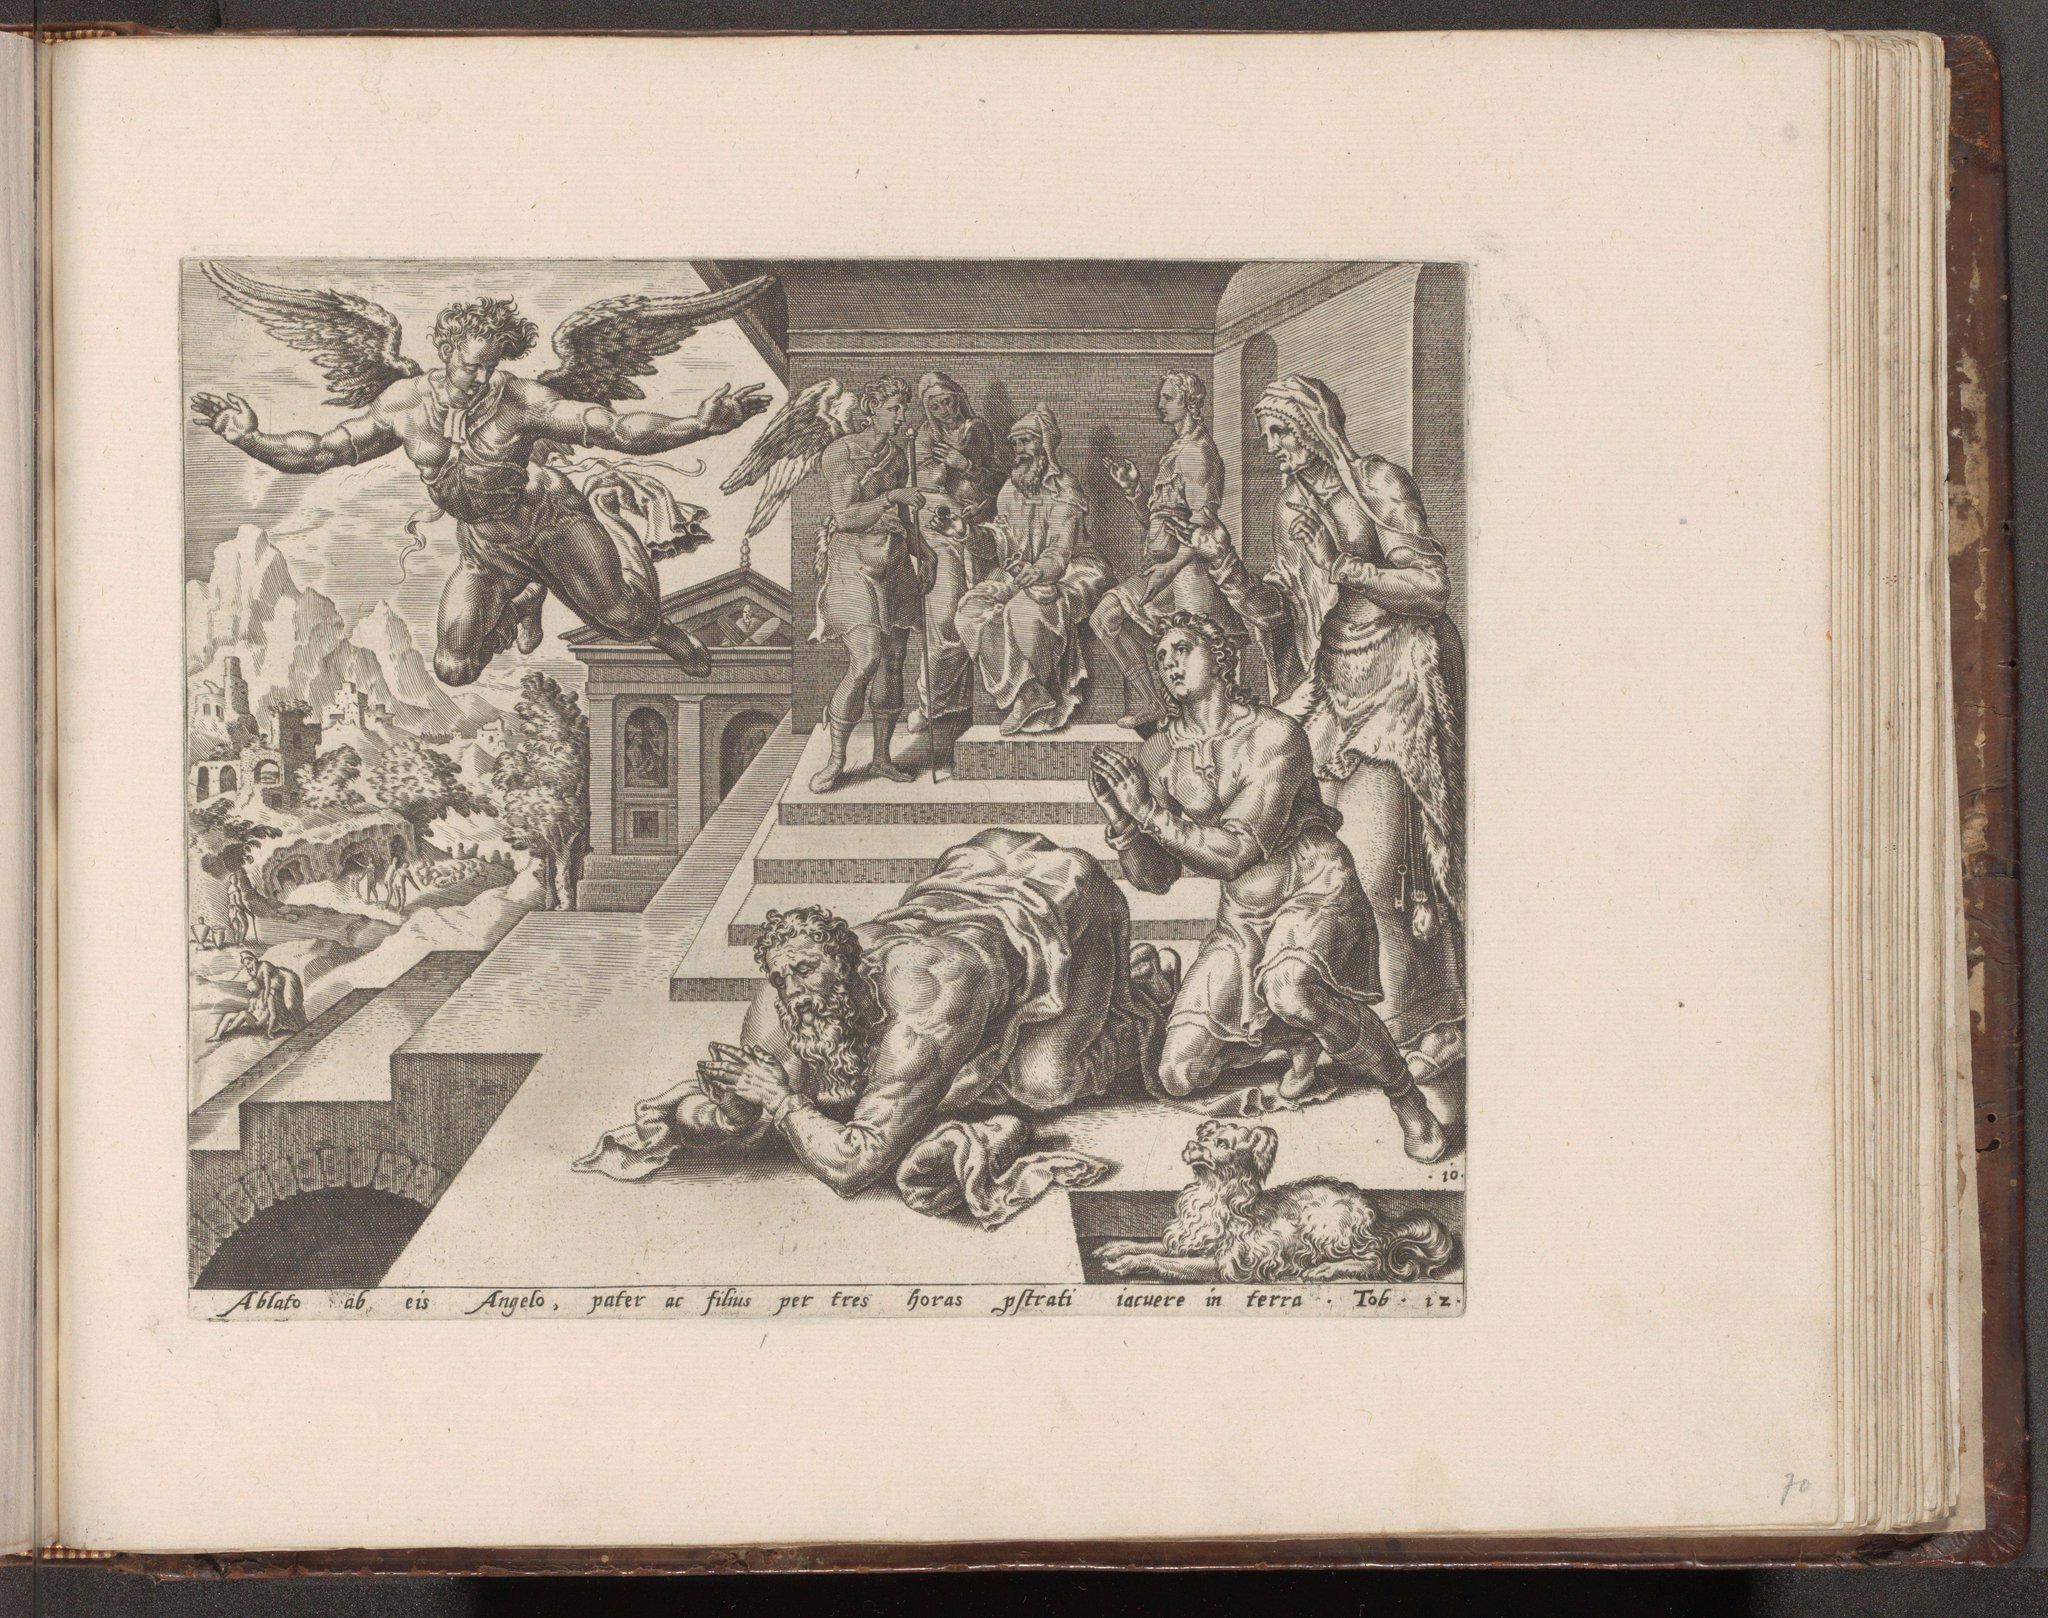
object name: album leaf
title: Vertrek van de engel Rafaël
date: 1556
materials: paper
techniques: engraving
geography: antwerp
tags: the angel raphael disappears into the sky, the angel makes himself known; tobias and his family lie down, the healing of tobit: tobias puts the gall of the fish on his father's eyes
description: Tobit en Tobias knielen op de grond nadat de aartsengel Rafaël zich bekend heeft gemaakt. De engel Rafaël vliegt weg. Op de achtergrond geneest Tobias zijn vaders blindheid met de vissengal. Onder de voorstelling een verwijzing naar de Bijbeltekst in Tobit 12 in het Latijn. Prent maakt deel uit van een album.